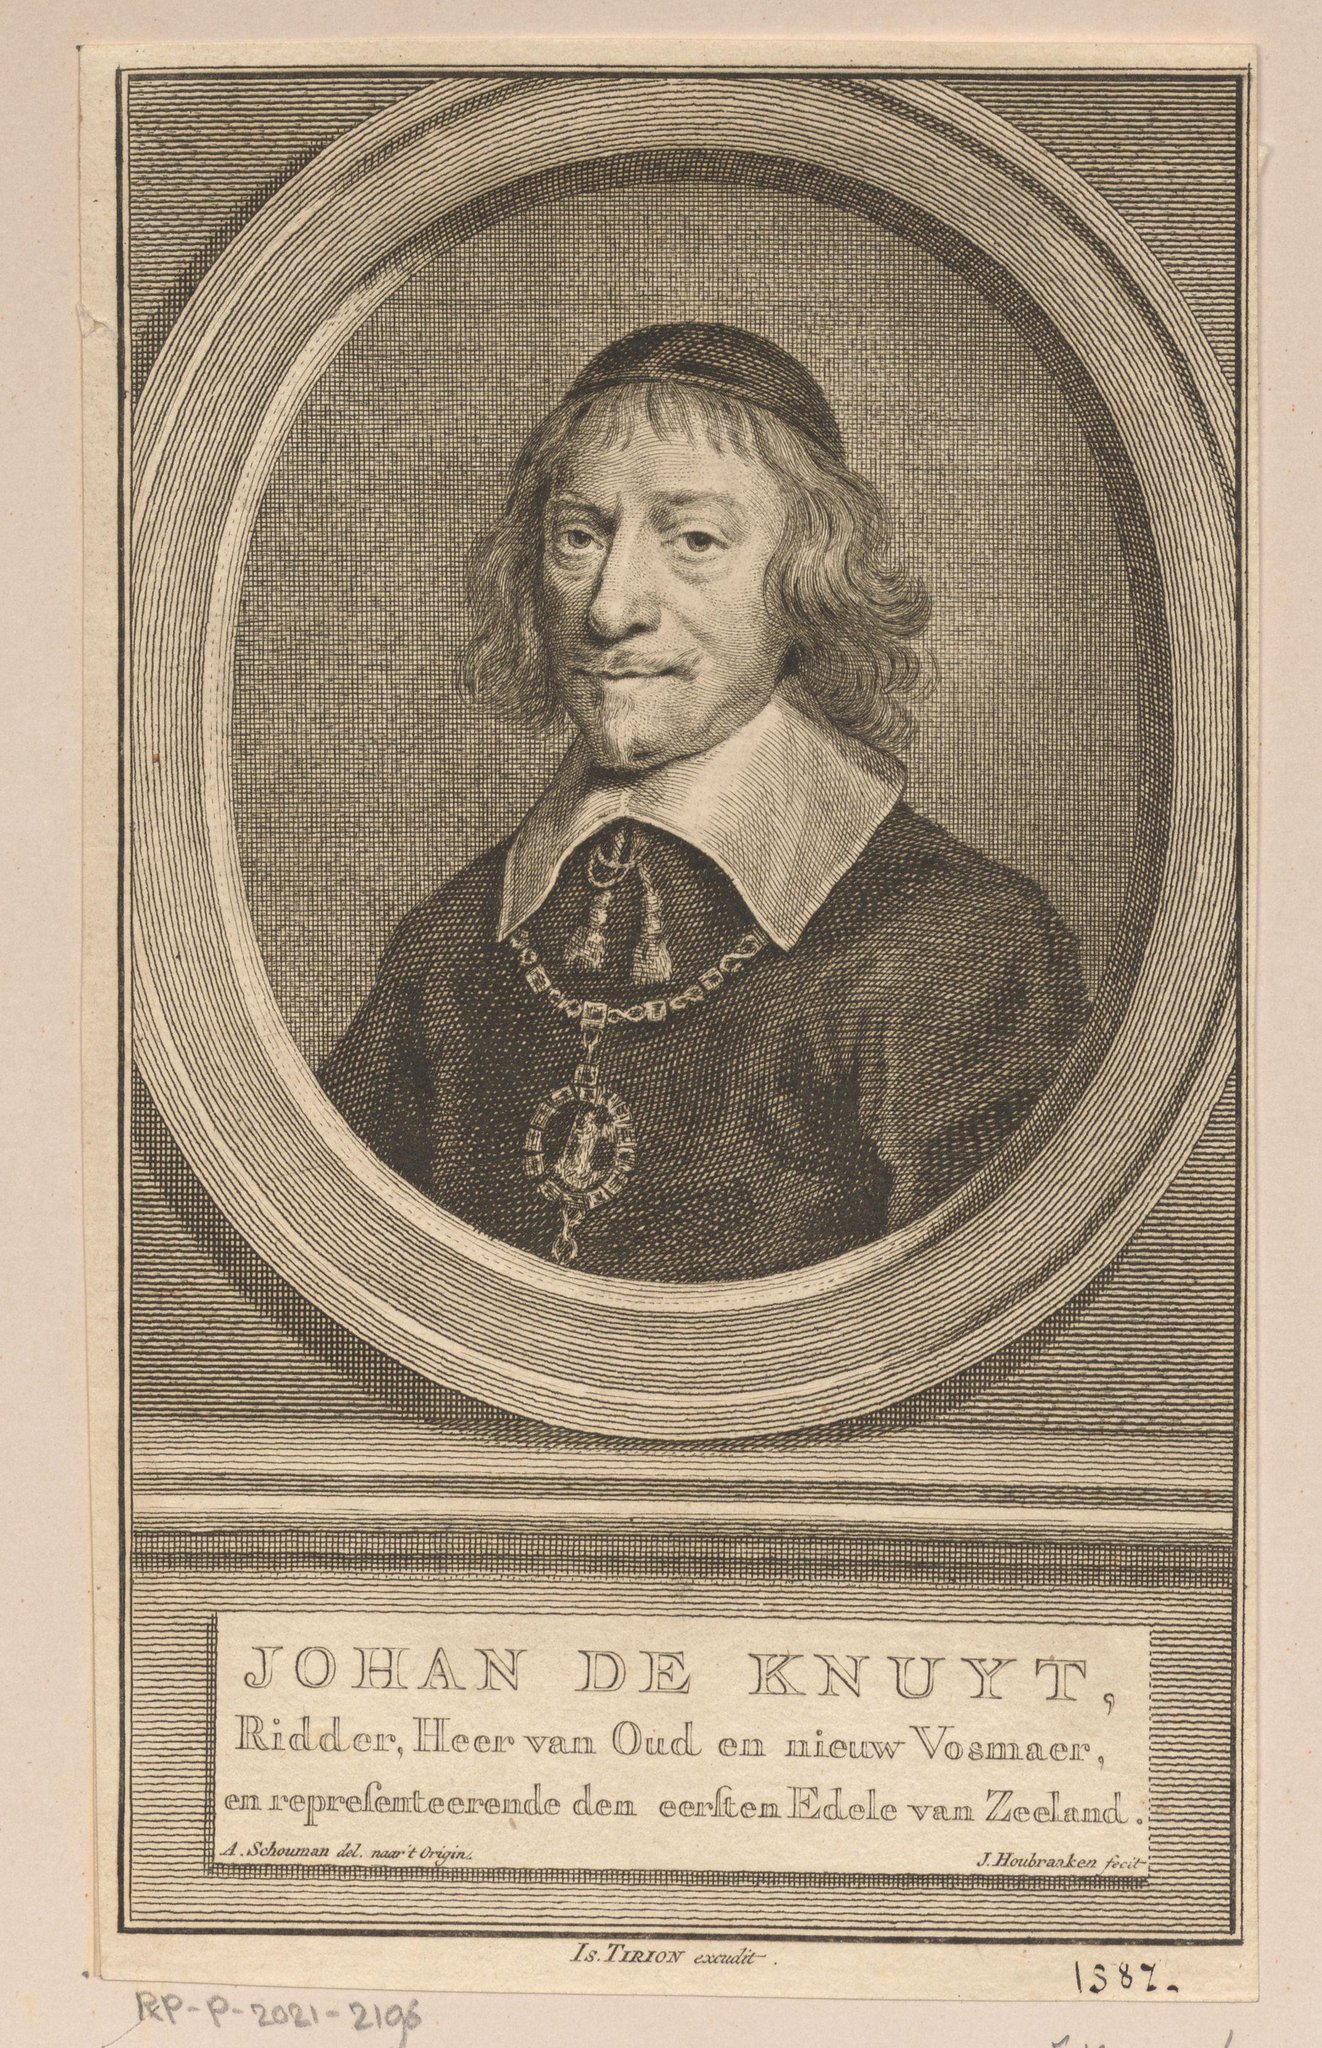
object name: print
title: Portret van Johan de Knuyt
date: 1754-1793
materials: paper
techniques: engraving, etching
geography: amsterdam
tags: historical persons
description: Prent mogelijk uit: Wagenaar, Jan. Vaderlandsche historie, vervattende de geschiedenissen der nu Vereenigde Nederlanden, inzonderheid die van Holland (...). 21 dln. Amsterdam: Isaak Tirion, 1754, dl. 11. Prent ook gebruikt in latere publicaties (1793).